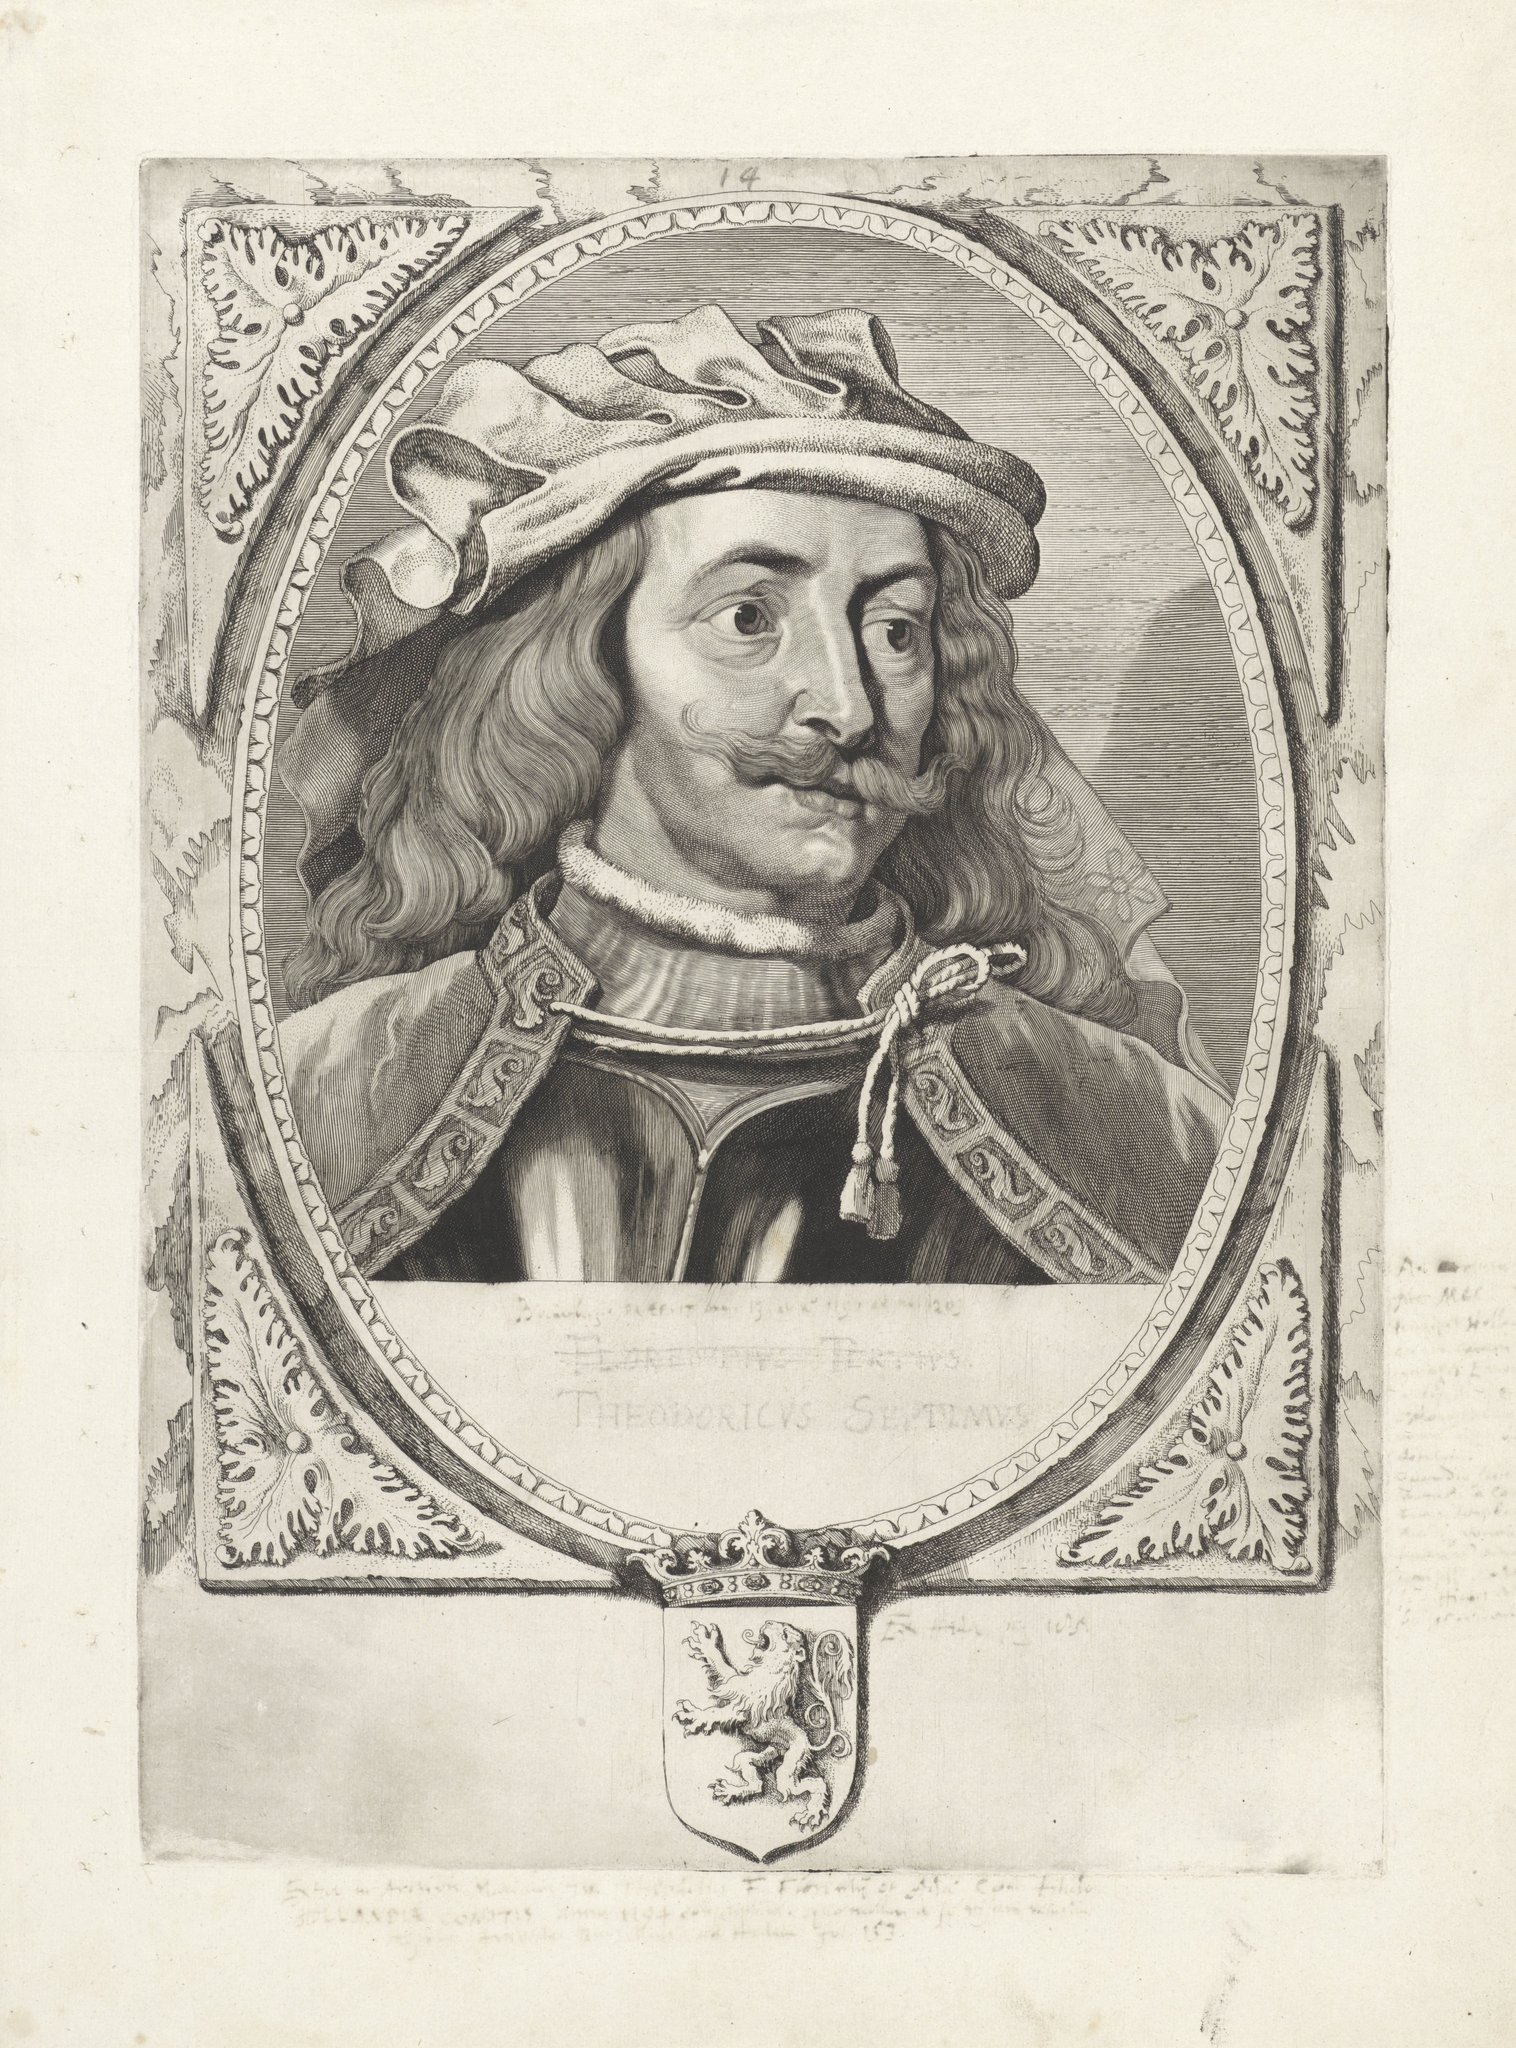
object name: print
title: Portret van Dirk VII, graaf van Holland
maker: cornelis visscher (ii)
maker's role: draughtsman, painter, print maker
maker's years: 1628-1658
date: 1650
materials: paper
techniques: engraving, etching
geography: haarlem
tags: dordrecht, head-gear, moustache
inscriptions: collector's mark: Lugt 240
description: Proefdruk van de veertiende prent uit de serie 'Graven en gravinnen van Holland, Zeeland en West-Friesland', bestaande uit 38 prenten.